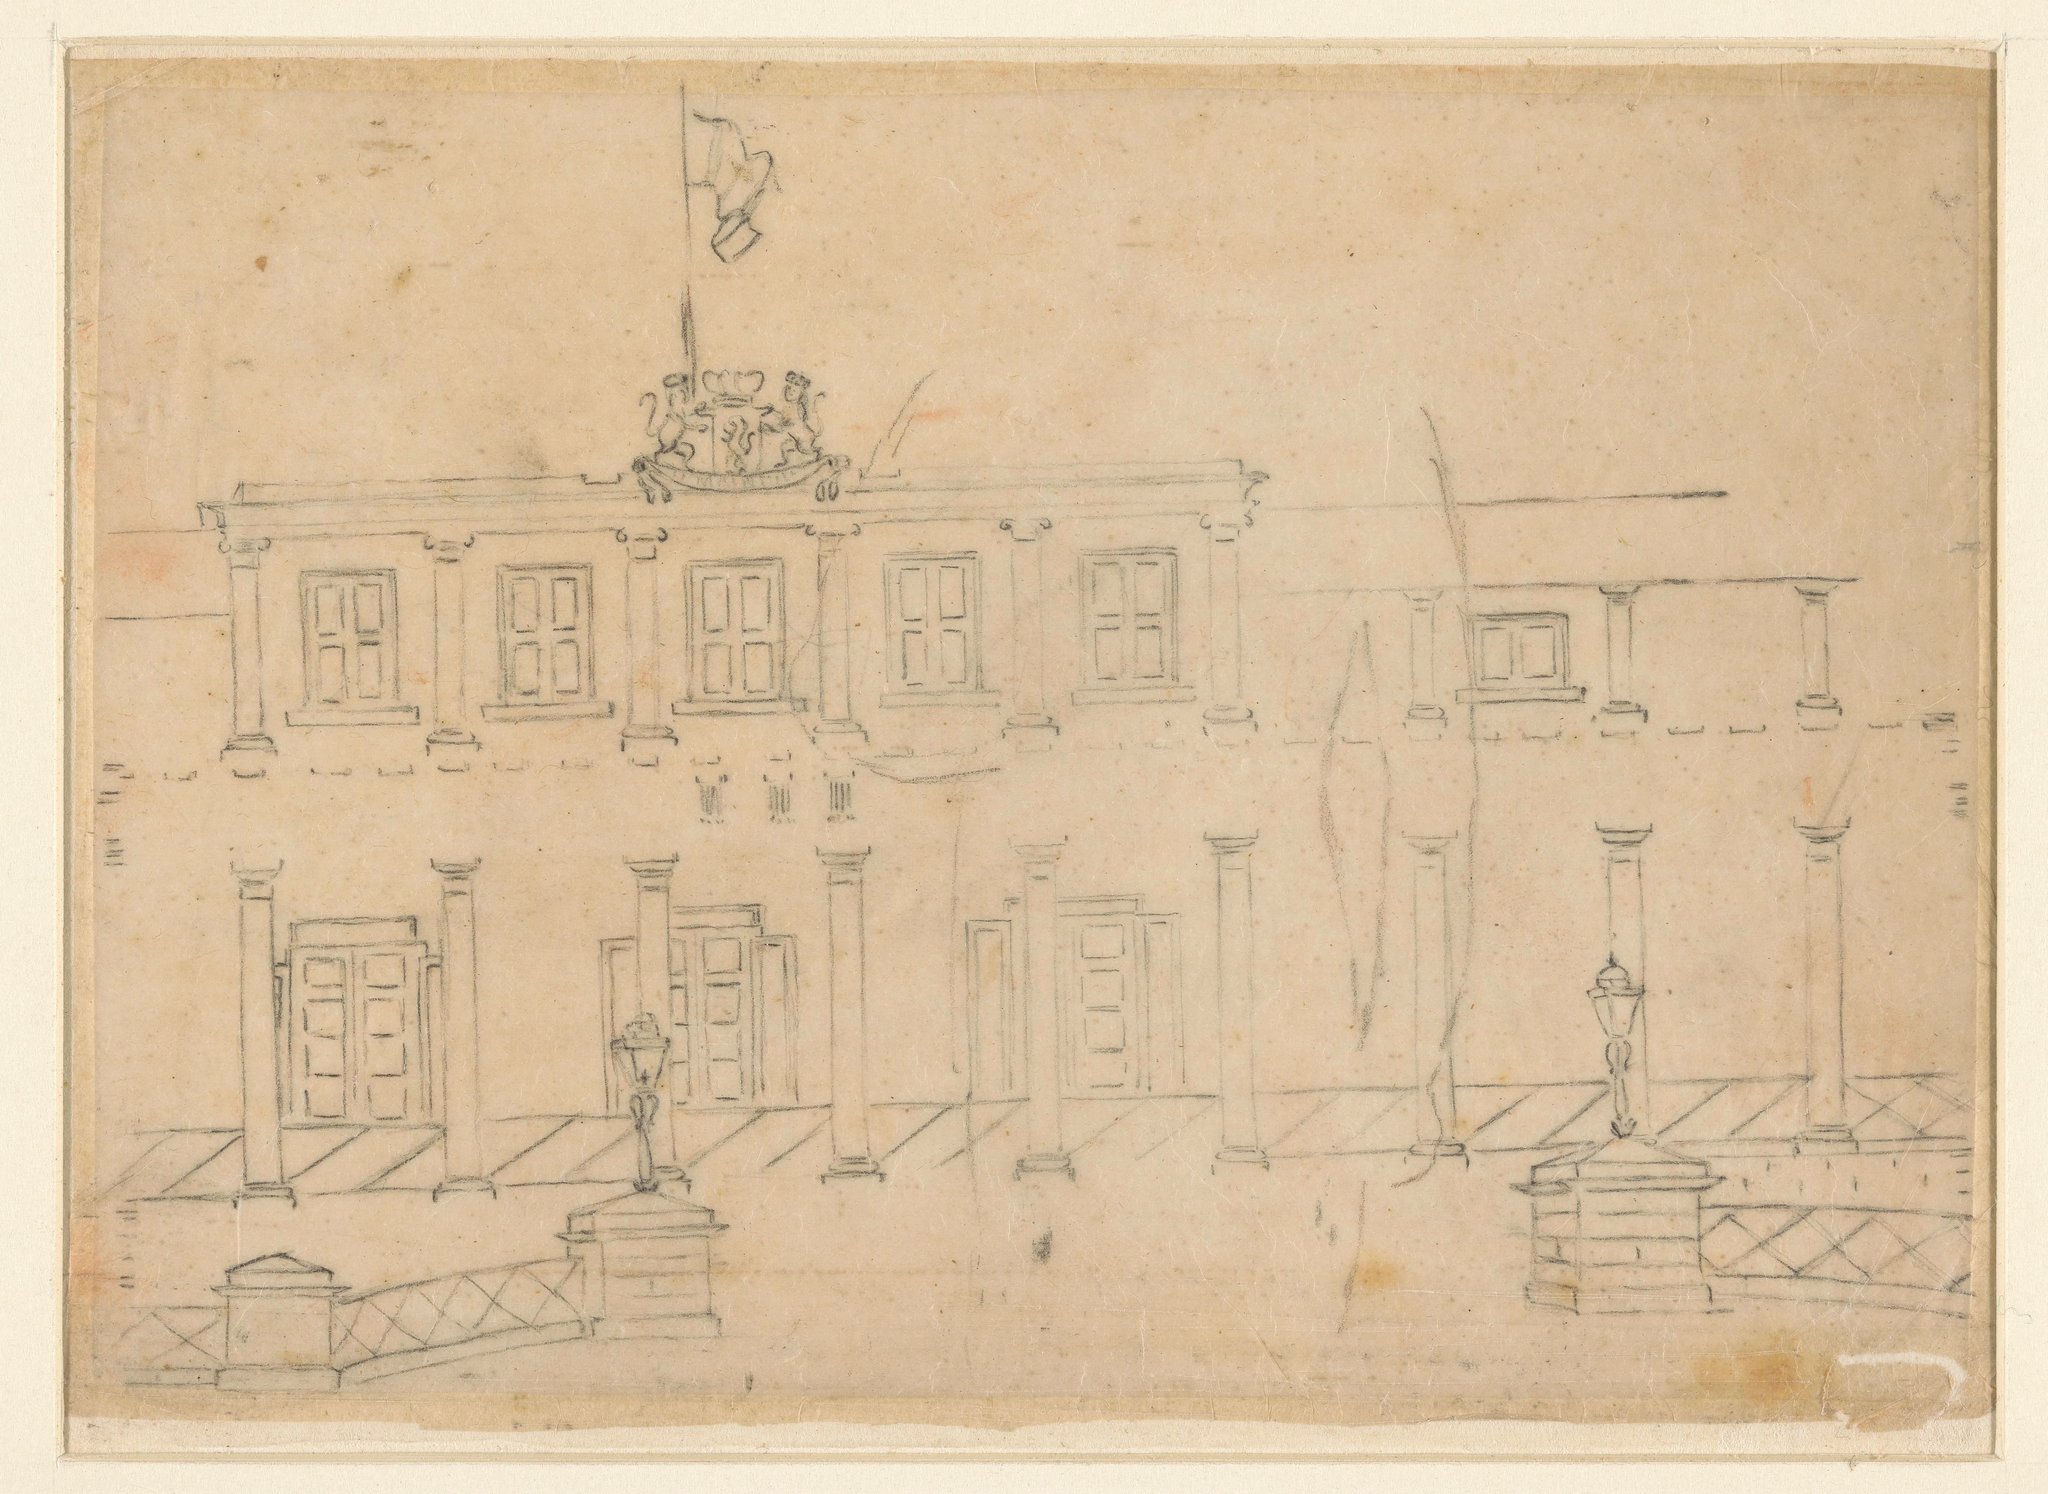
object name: drawing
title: Gevel van een regeringsgebouw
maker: frederik hendrik weissenbruch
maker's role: draughtsman, print maker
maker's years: 1828-1887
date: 1838-1887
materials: pencil, paper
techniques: pouncing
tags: civic architecture; edifices; dwellings